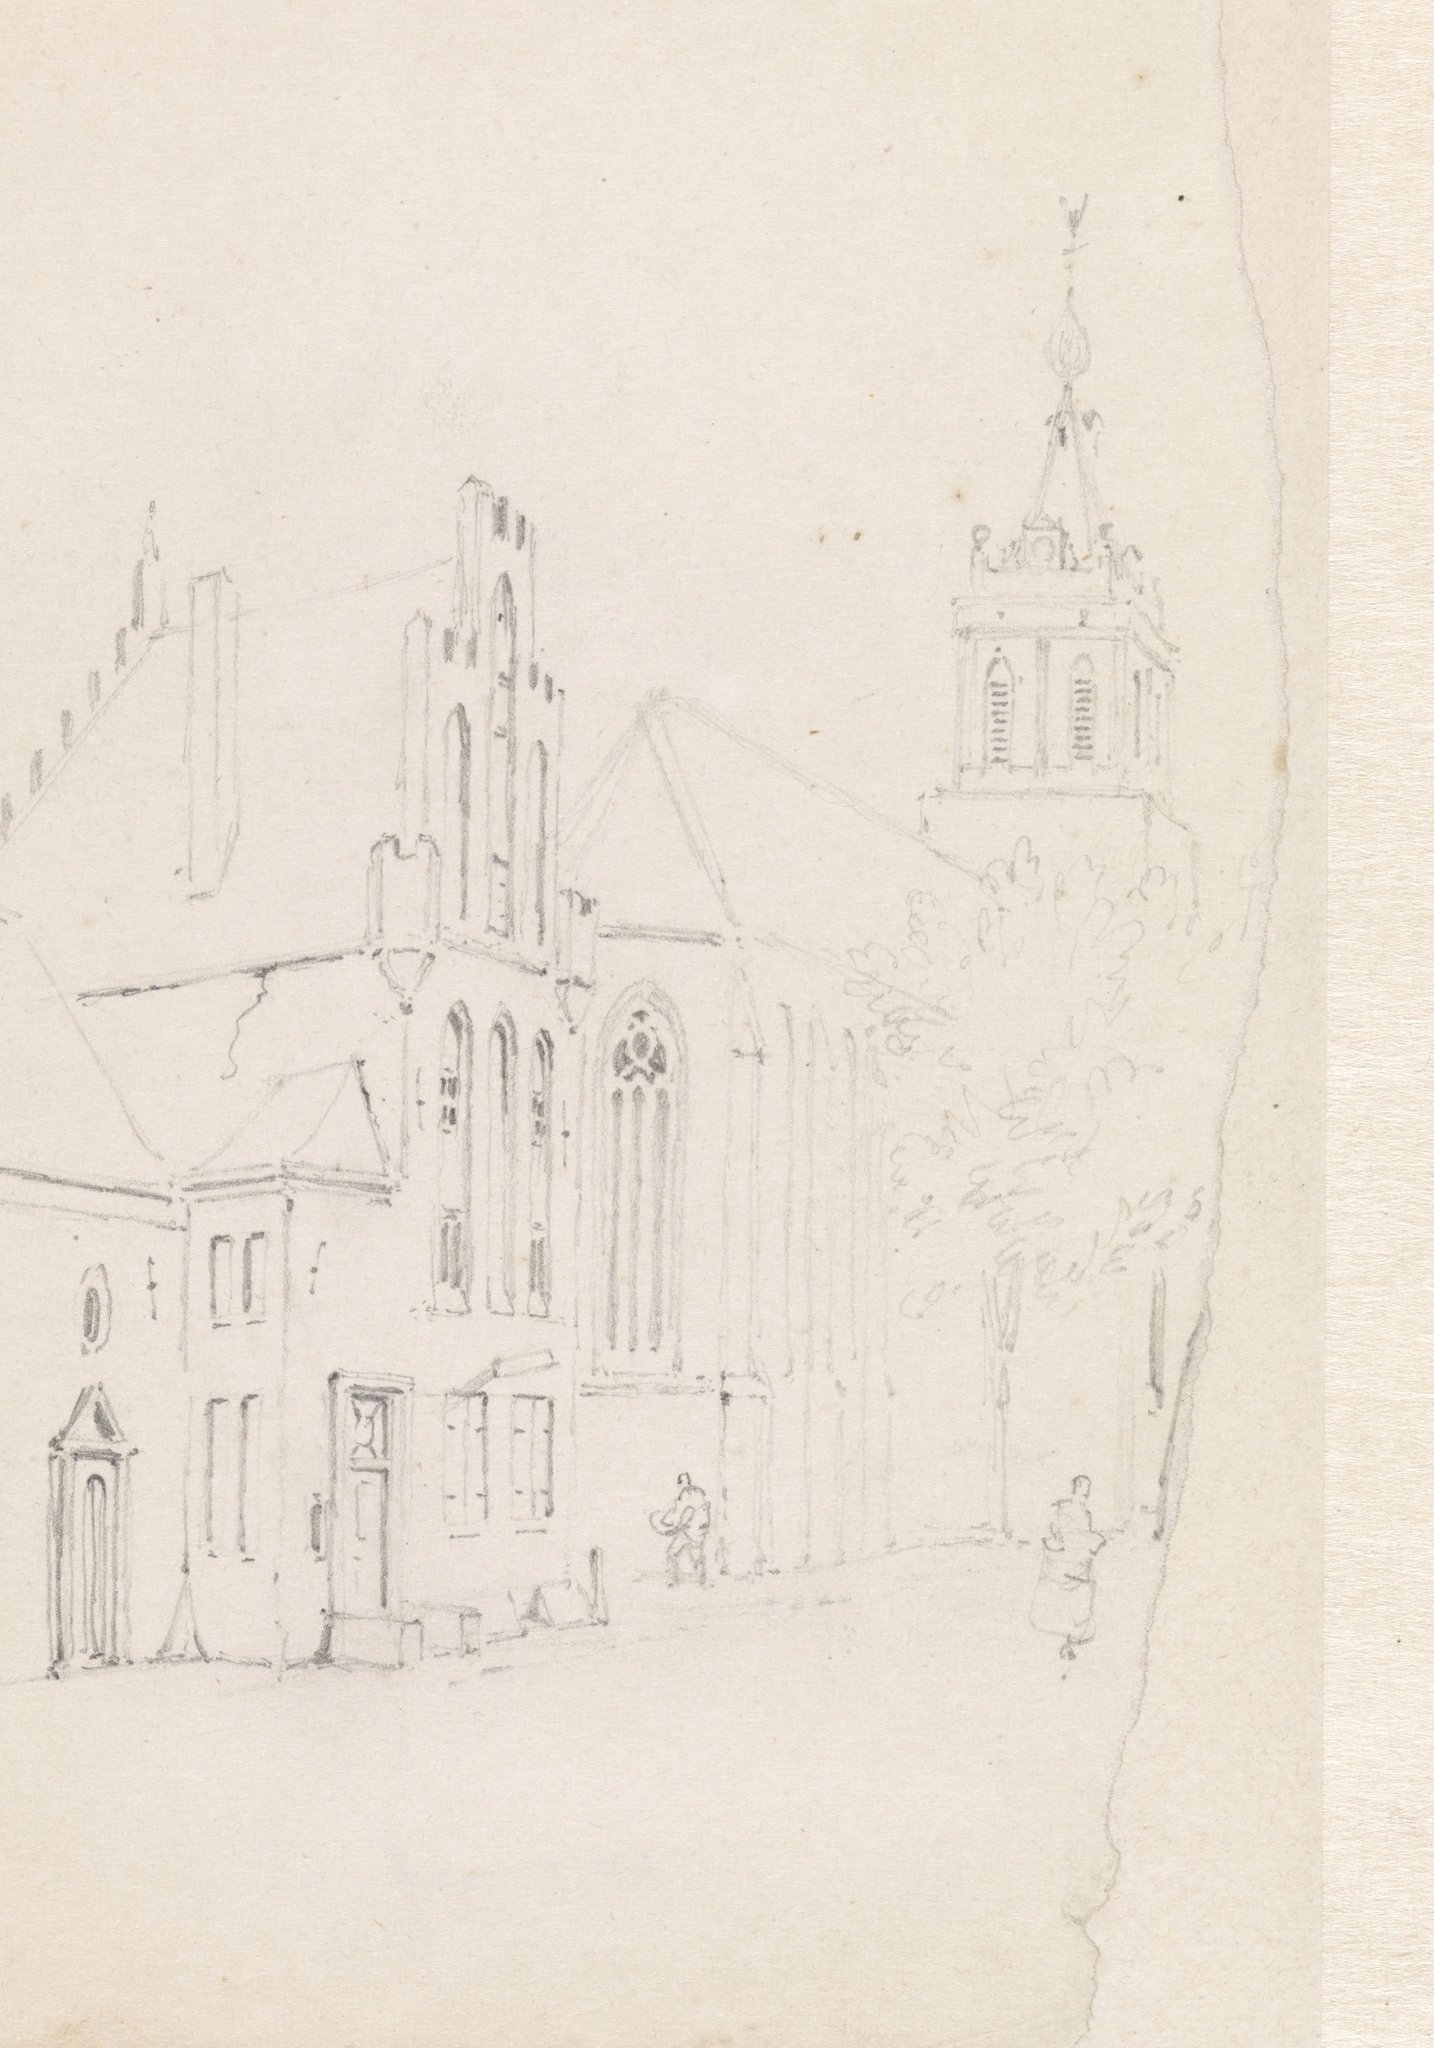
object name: drawing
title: Stadsgezicht met kerk en huizen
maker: adrianus eversen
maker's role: draughtsman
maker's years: 1818-1897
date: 1828-1897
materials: paper, pencil